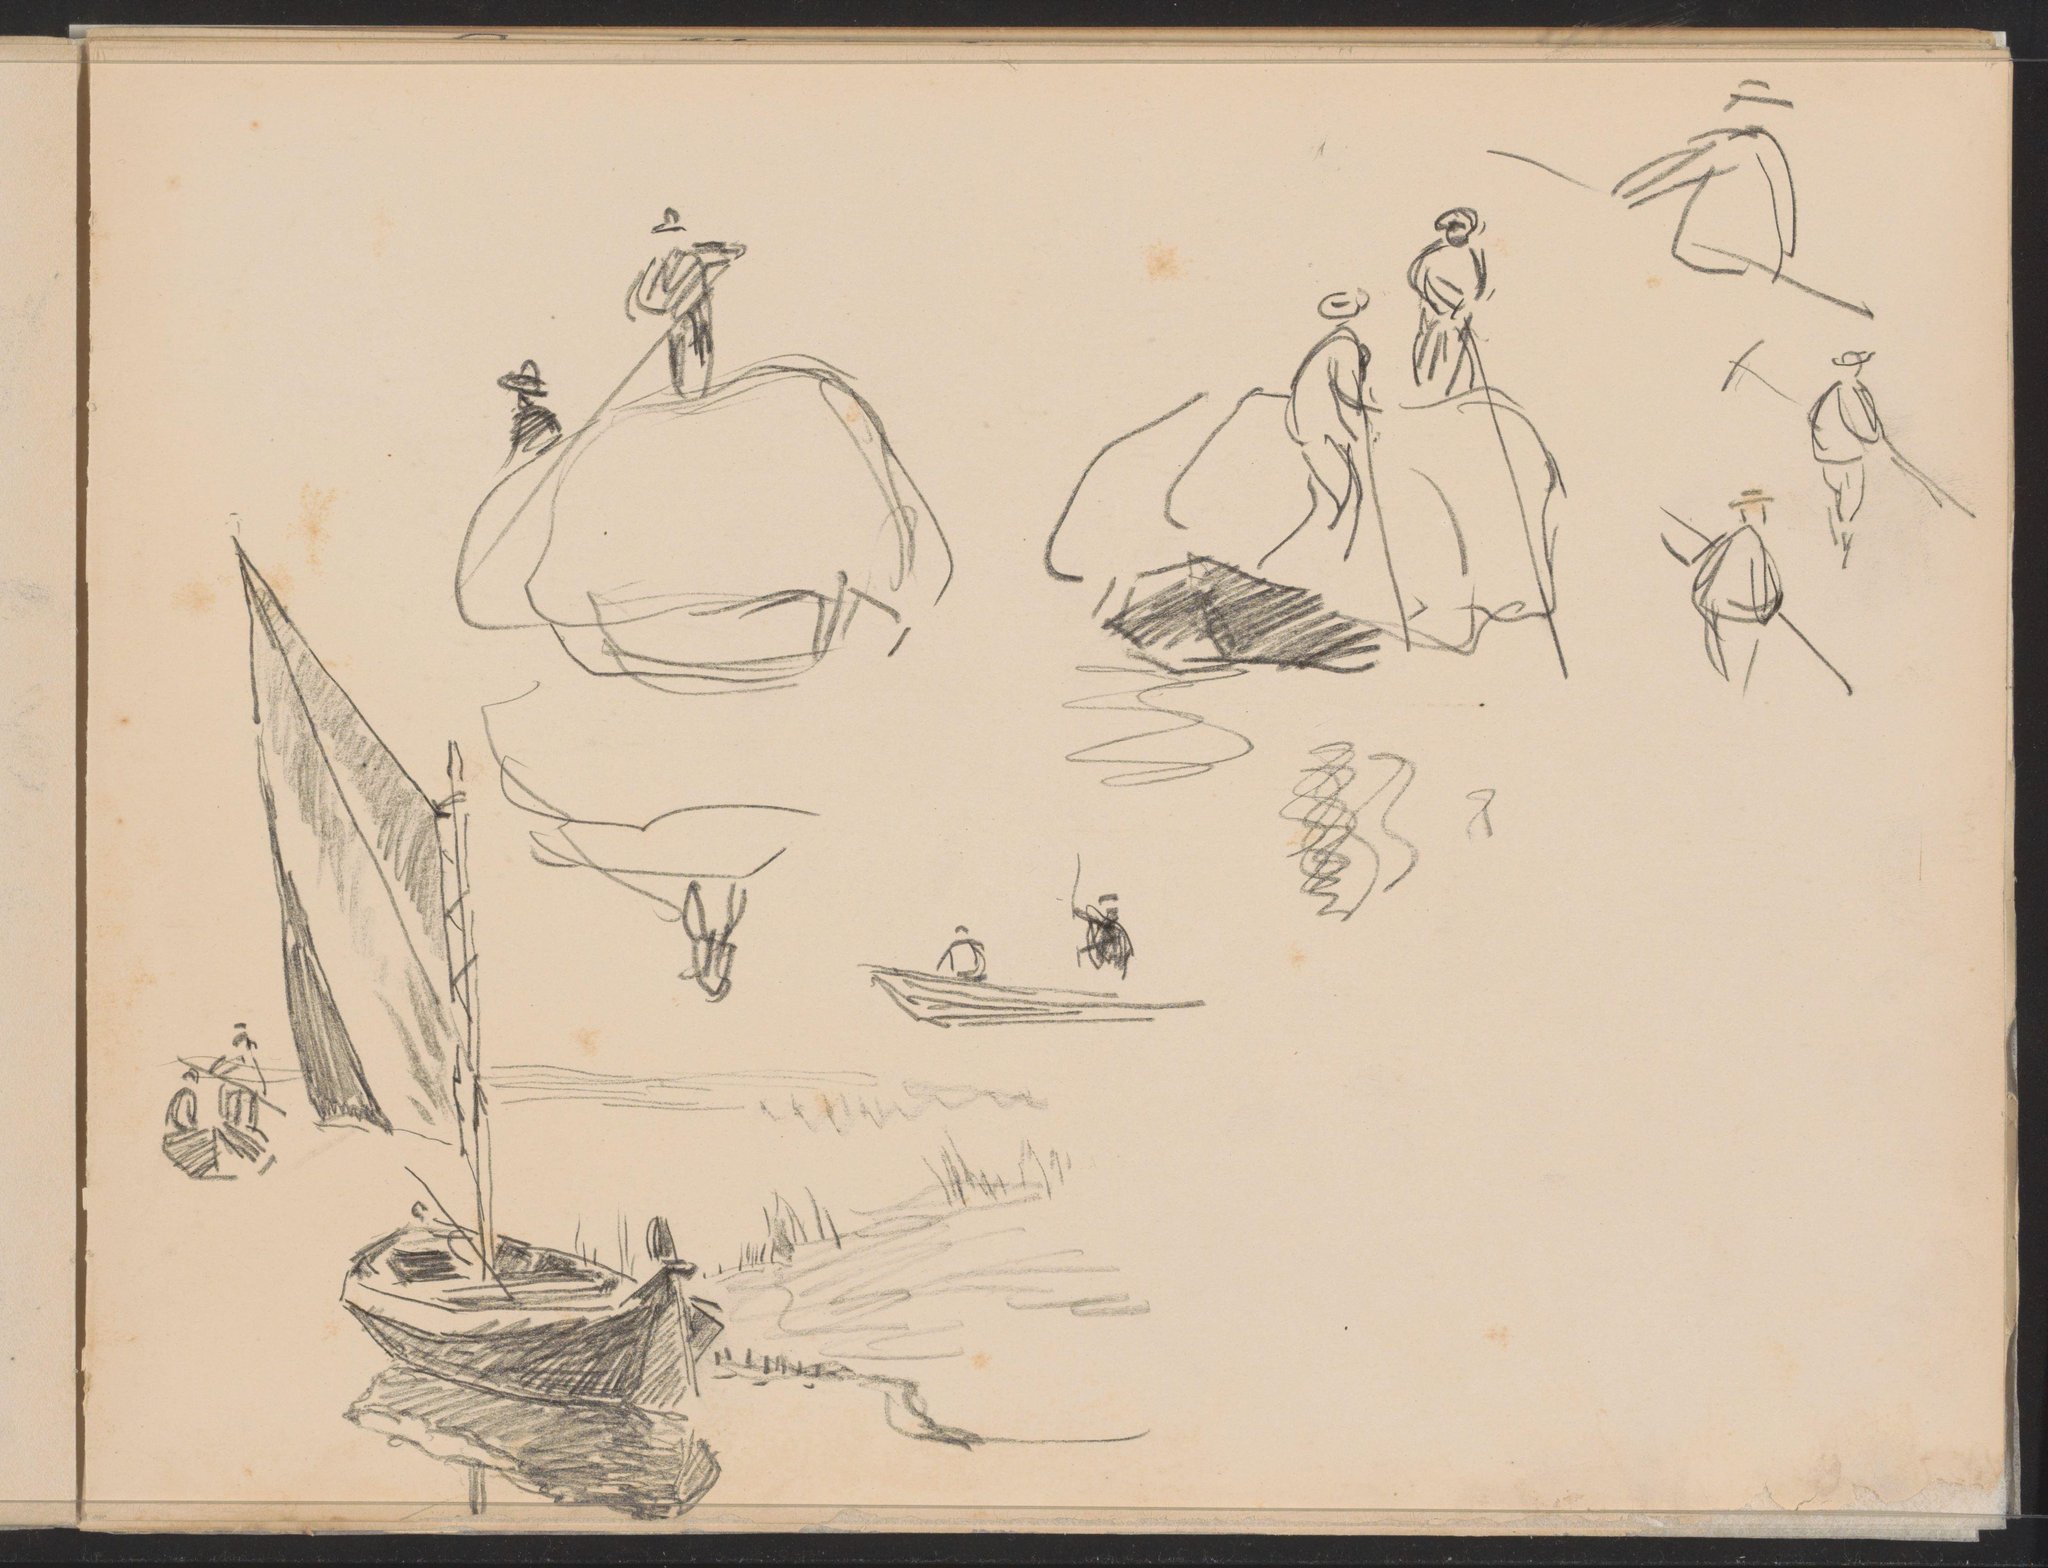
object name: sketchbook leaf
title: Studieblad, onder andere met een aangemeerd zeilschip, roeiboten en figuren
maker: willem bastiaan tholen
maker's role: draughtsman, painter, print maker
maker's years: 1860-1931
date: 1870-1931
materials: chalk, paper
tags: sailing-ship, sailing-boat, adult man, rowing-boat, canoe, etc.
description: Blad 17 recto uit een schetsboek met 28 bladen.